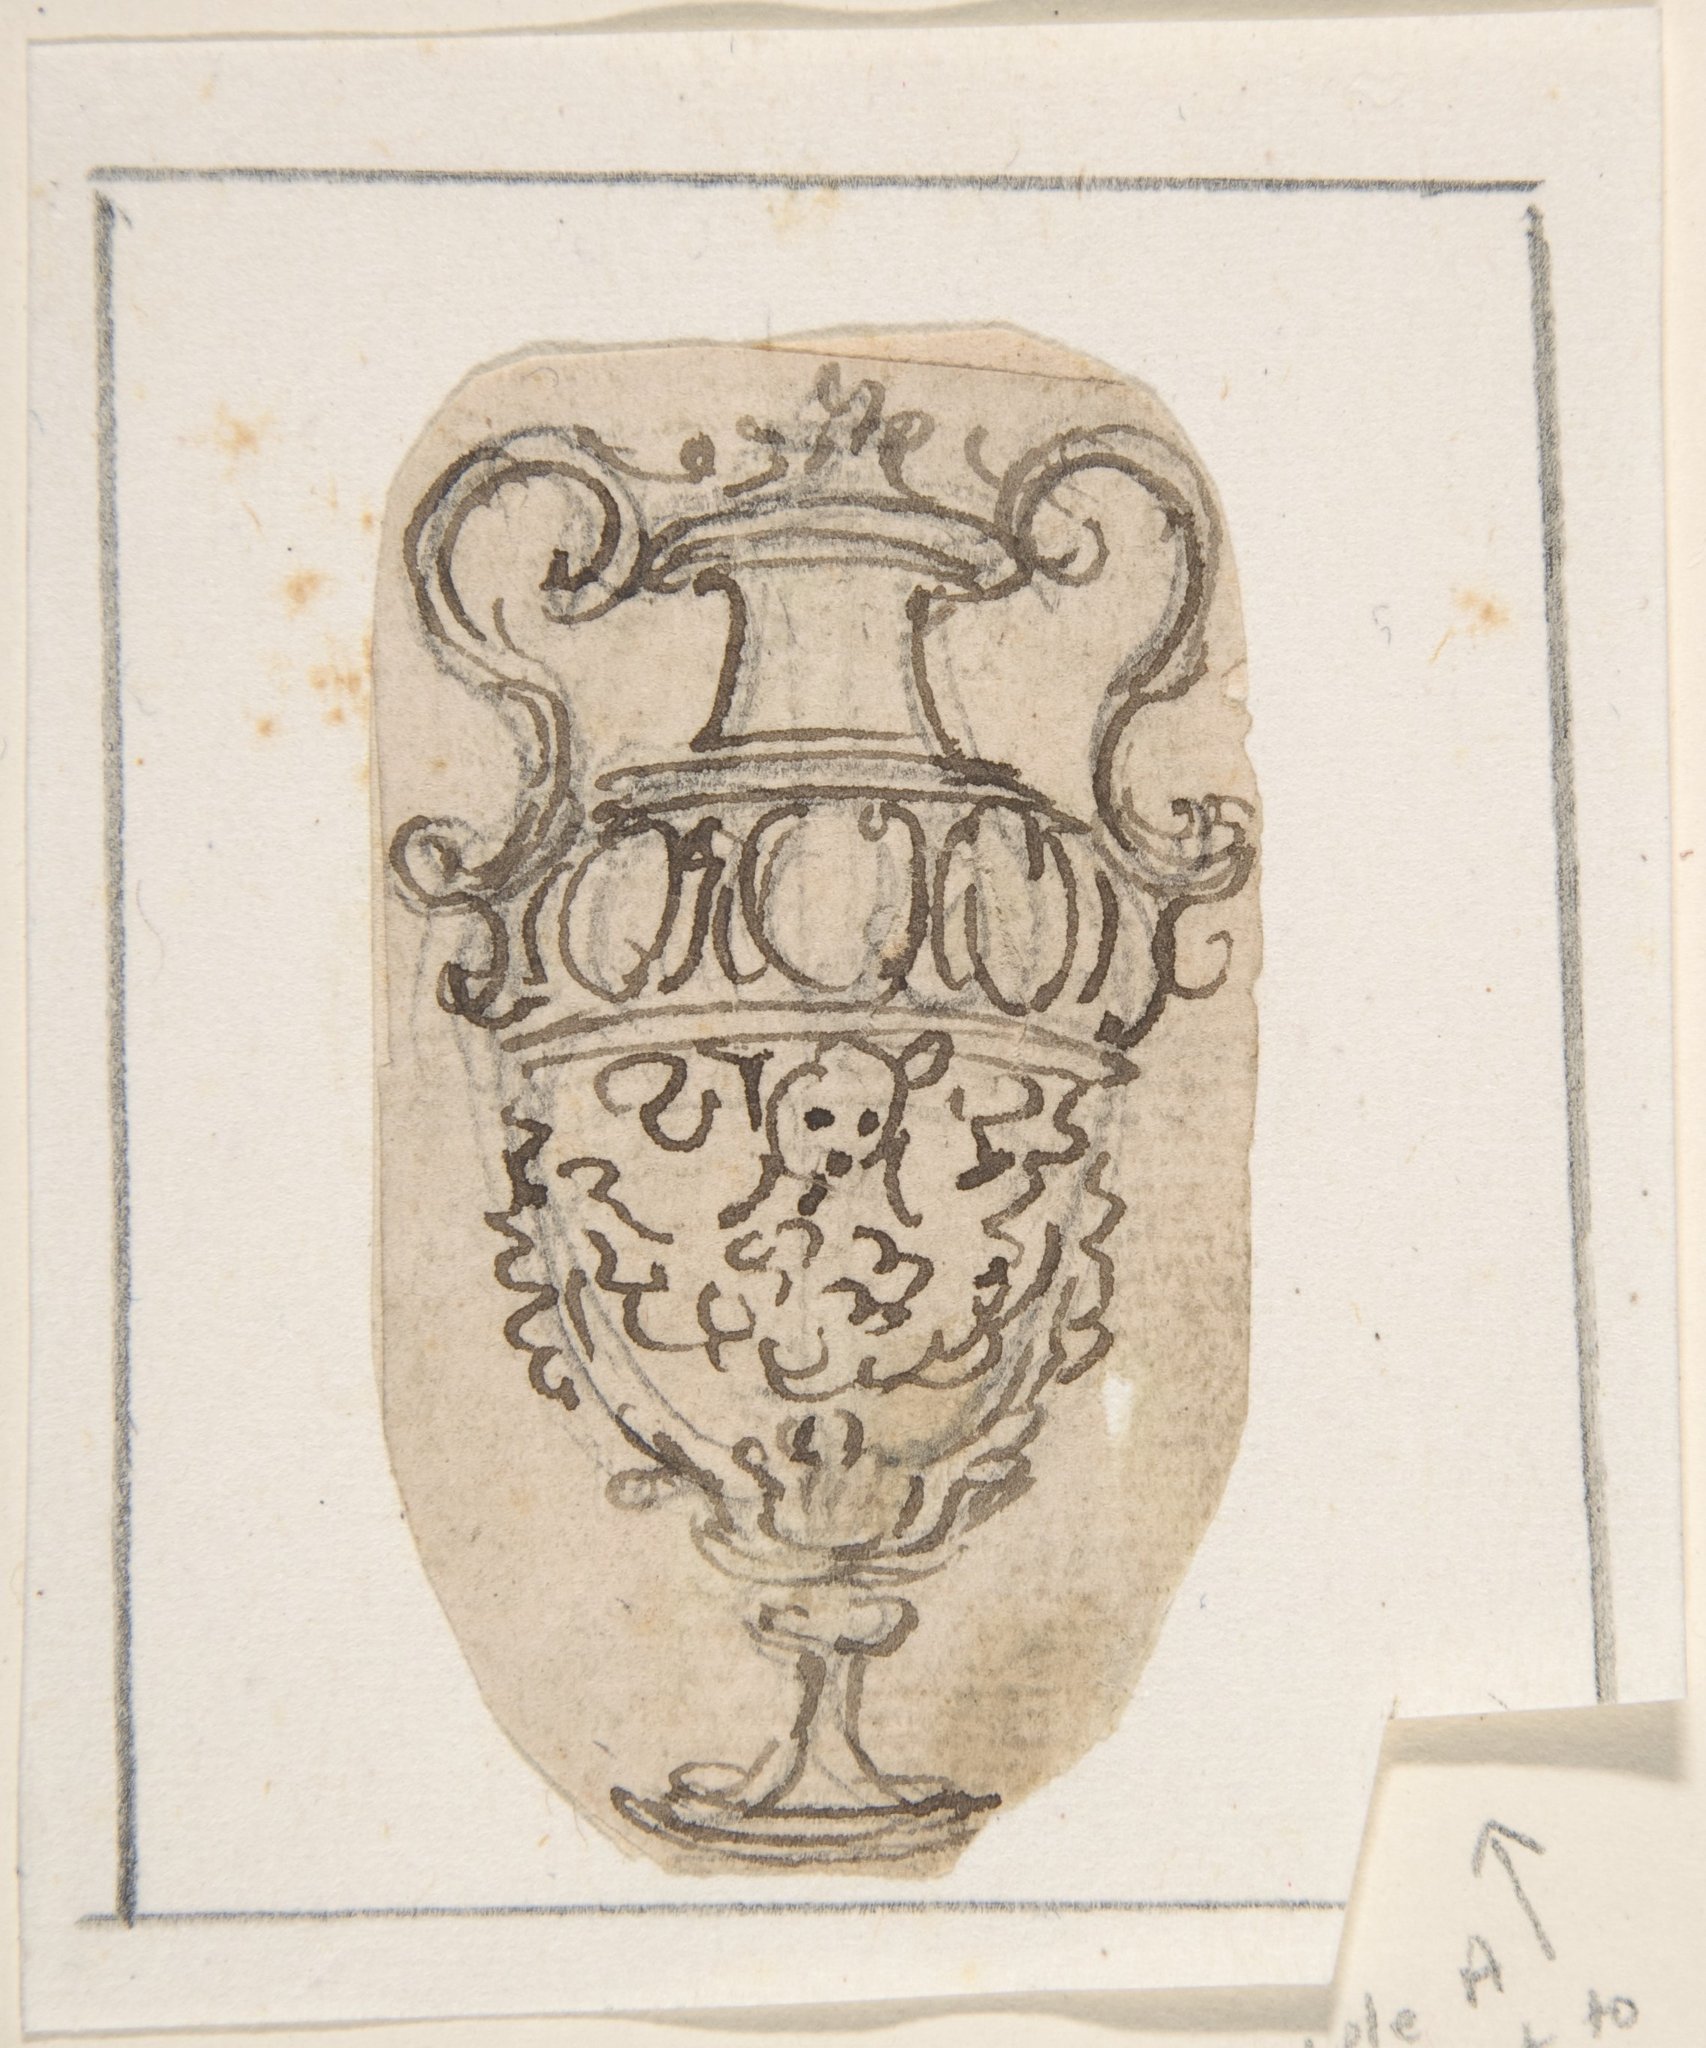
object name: drawing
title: Outline of Design for a Vase with Two Handles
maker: giovanni battista foggini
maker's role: artist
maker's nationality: italian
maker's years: 1652-1725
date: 1672-1725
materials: chalk, graphite, ink, paper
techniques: pen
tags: vases